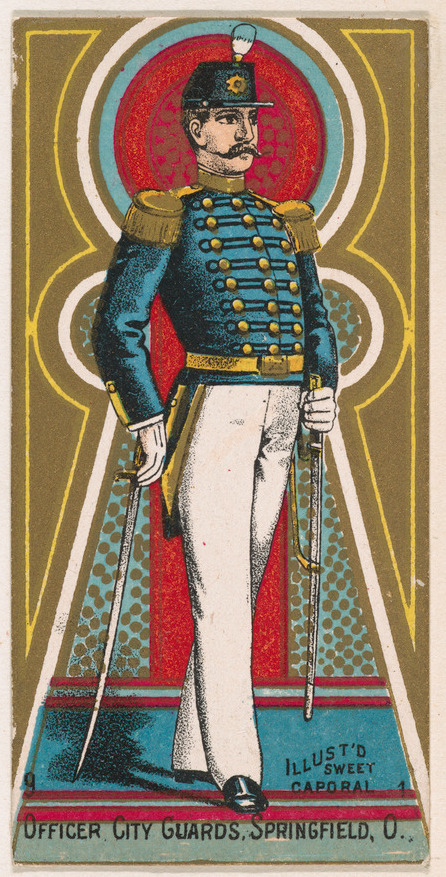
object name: print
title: Officer, City Guards, Springfield, Ohio, from the Military Series (N224) issued by Kinney Tobacco Company to promote Sweet Caporal Cigarettes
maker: kinney brothers tobacco company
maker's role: publisher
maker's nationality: american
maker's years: 1869-2011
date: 1888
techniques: color lithograph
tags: military,swords,men